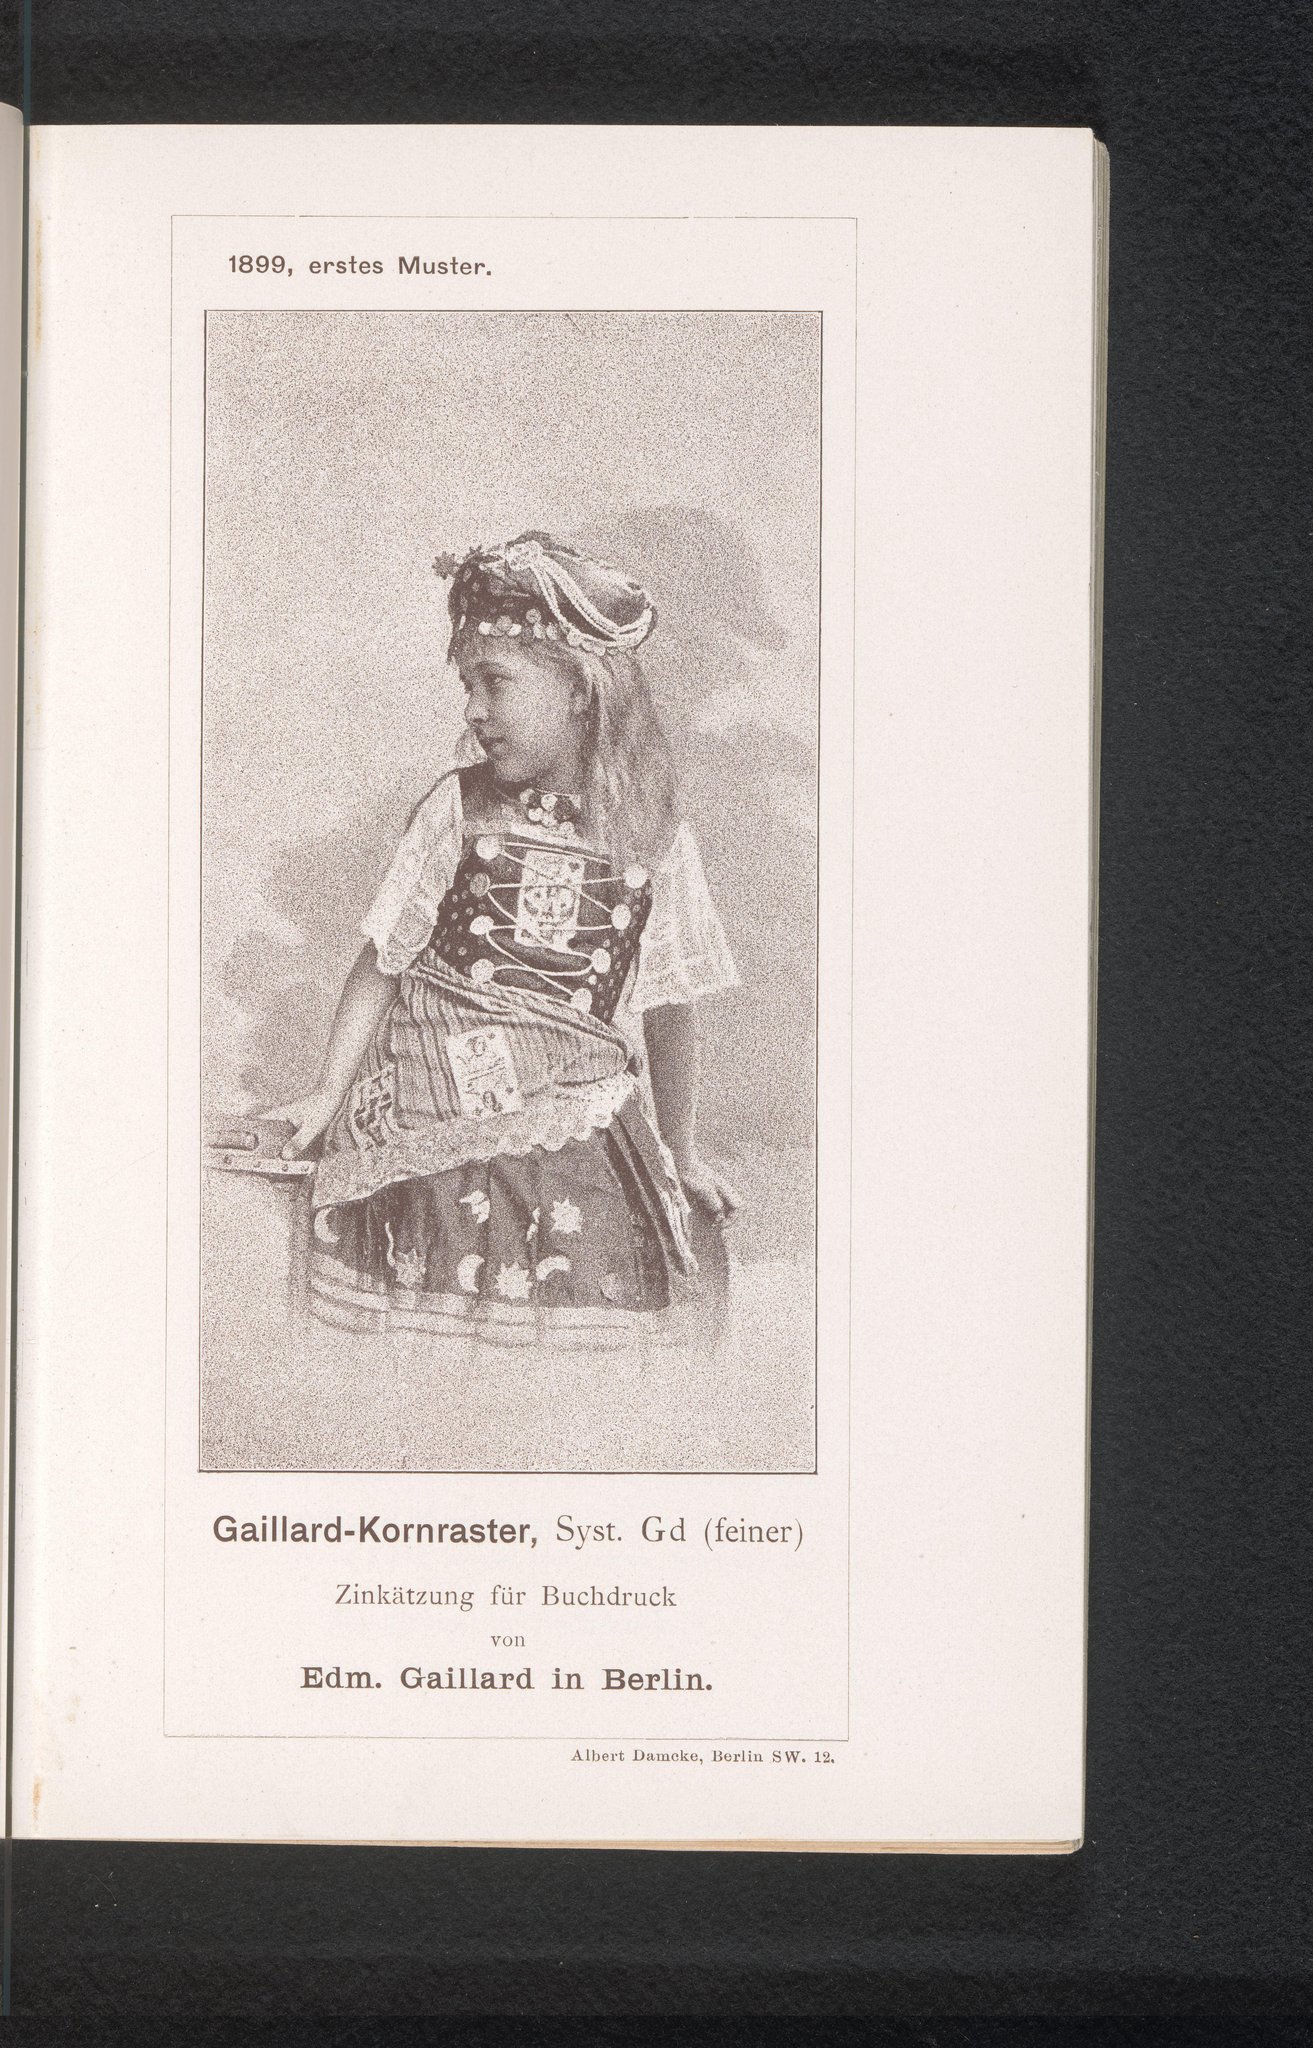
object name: page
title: Portret van een onbekend meisje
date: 1894-1899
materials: paper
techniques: collo-autotype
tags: historical persons, girl (child between toddler and youth)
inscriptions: inscription: ‘1899, erstes Muster./ Gaillard-Kornraster, Syst. Gd (Feiner)/ Zinkätzung für Buchdruck (...)’